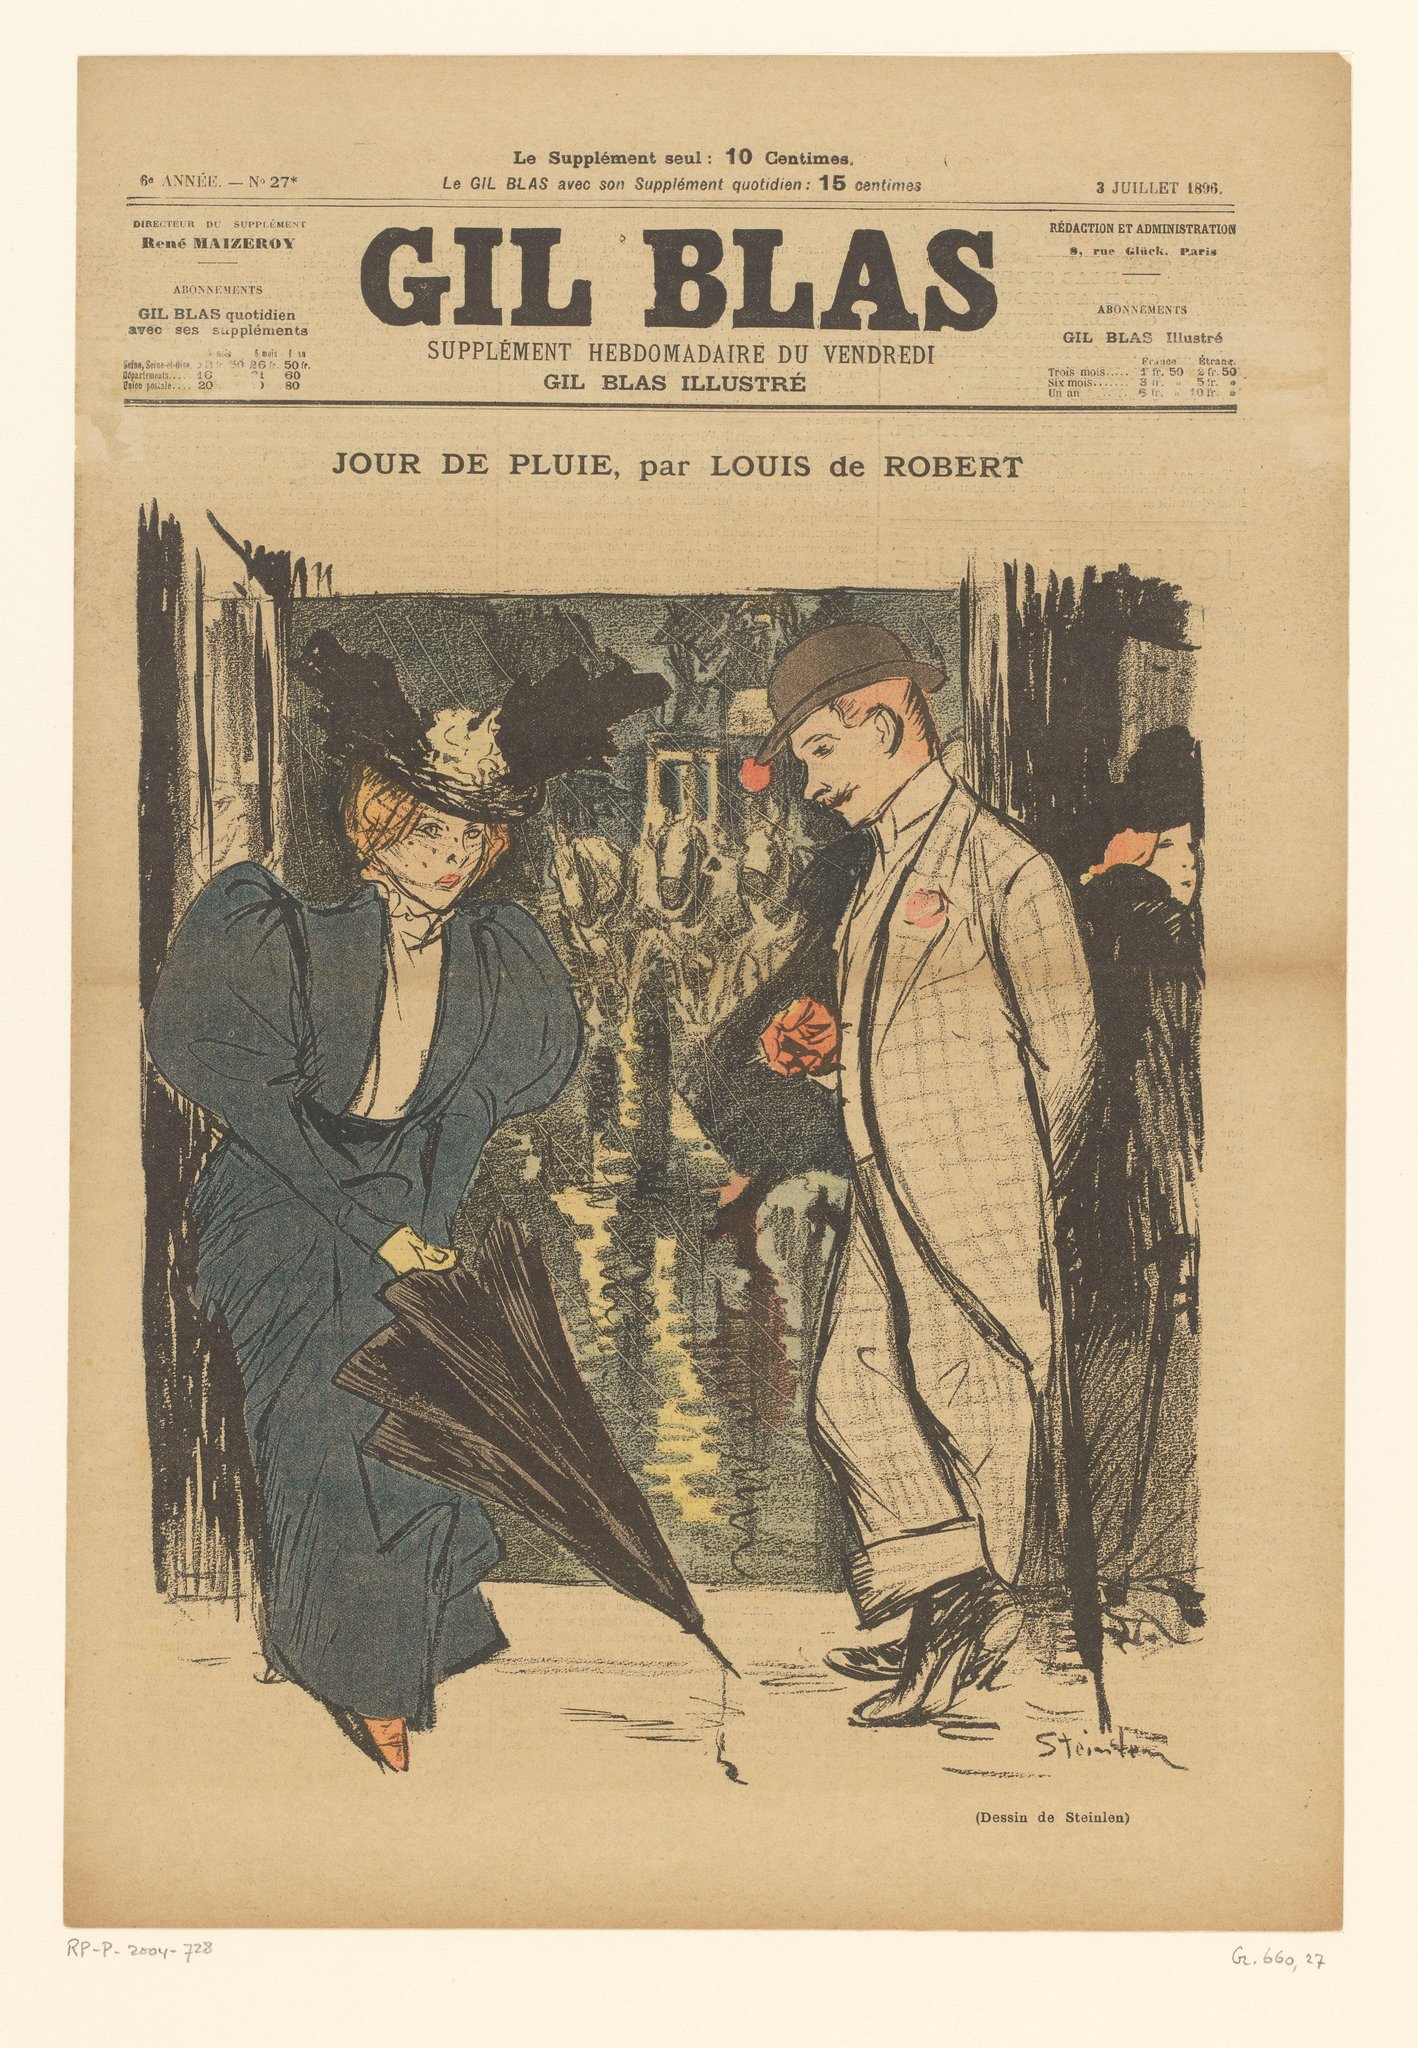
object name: print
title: Jour de pluie, par Louis de Robert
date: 1896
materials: paper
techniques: lithograph, letterpress printing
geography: paris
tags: adult woman, adult man, umbrella, flowers: rose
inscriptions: collector's mark: Lugt 2228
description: Prent uit: Gil Blas 6 (1896), nr. 27, 3 juli 1896.